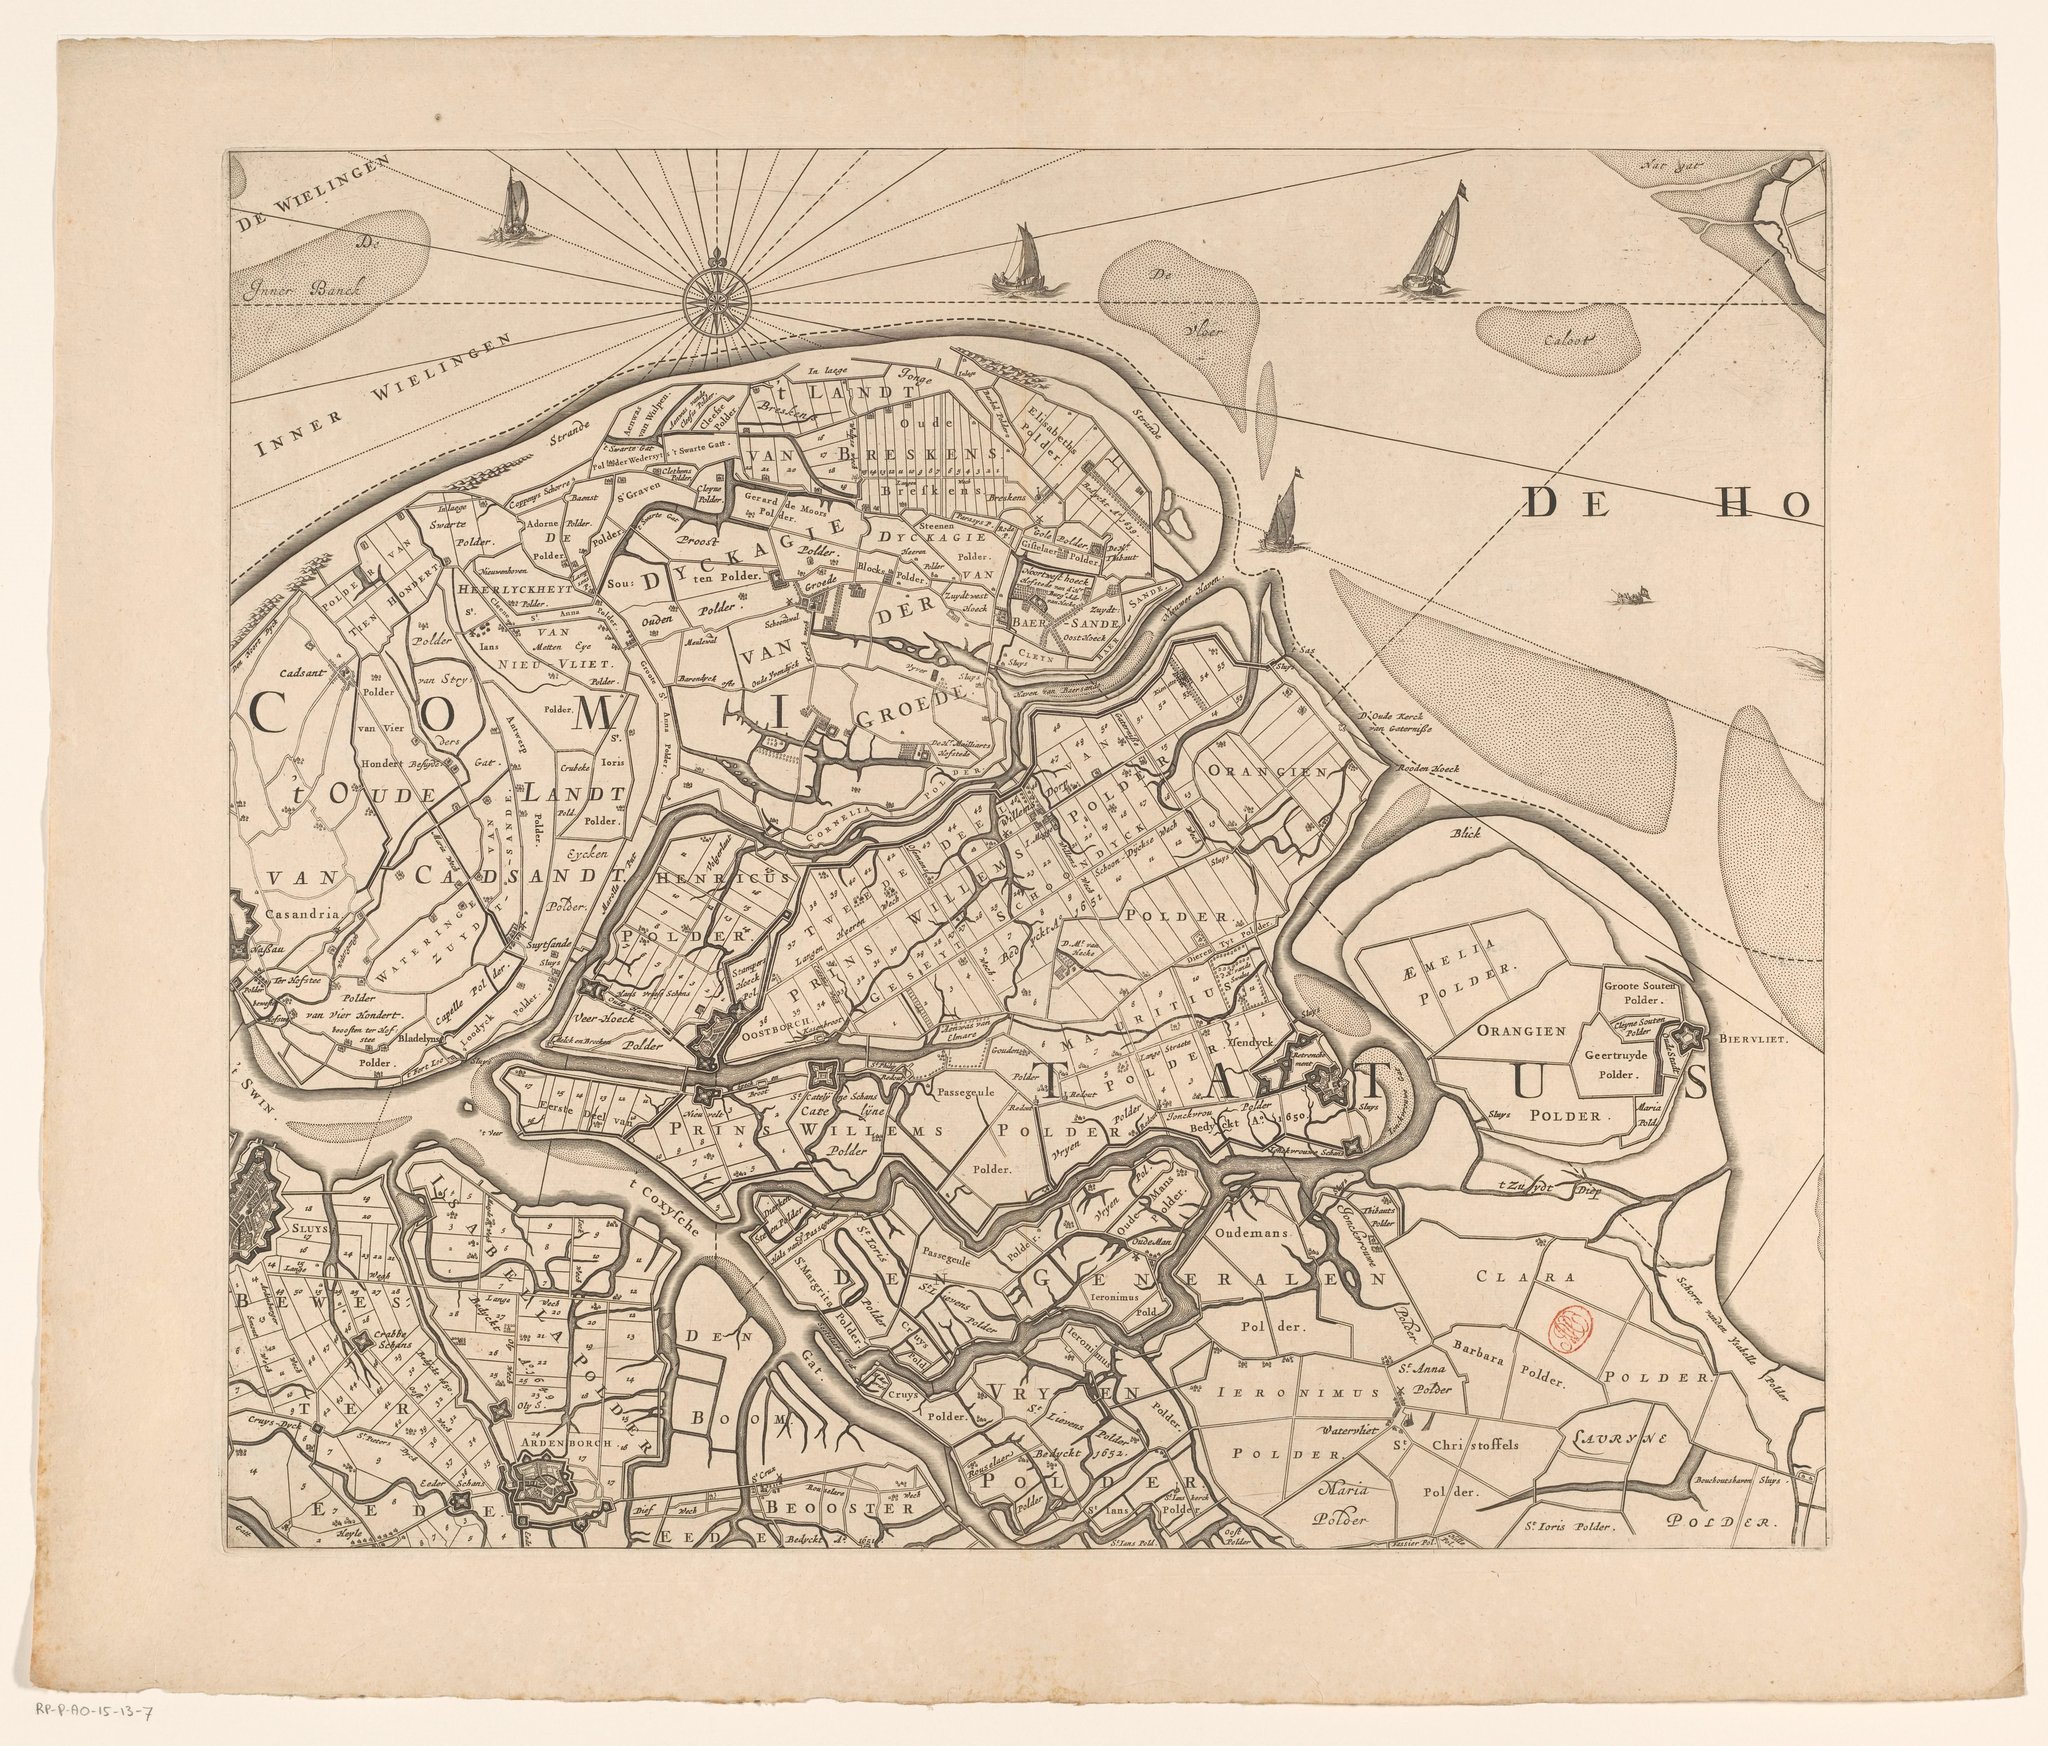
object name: print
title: Kaart van Zeeland (zevende deel)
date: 1655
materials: paper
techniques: engraving, etching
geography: amsterdam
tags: maps of separate countries or regions, zeeland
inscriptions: collector's mark: Lugt 195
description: Zevende deel van een kaart van Zeeland, bestaande uit negen delen. Rechtsonder genummerd: 7.